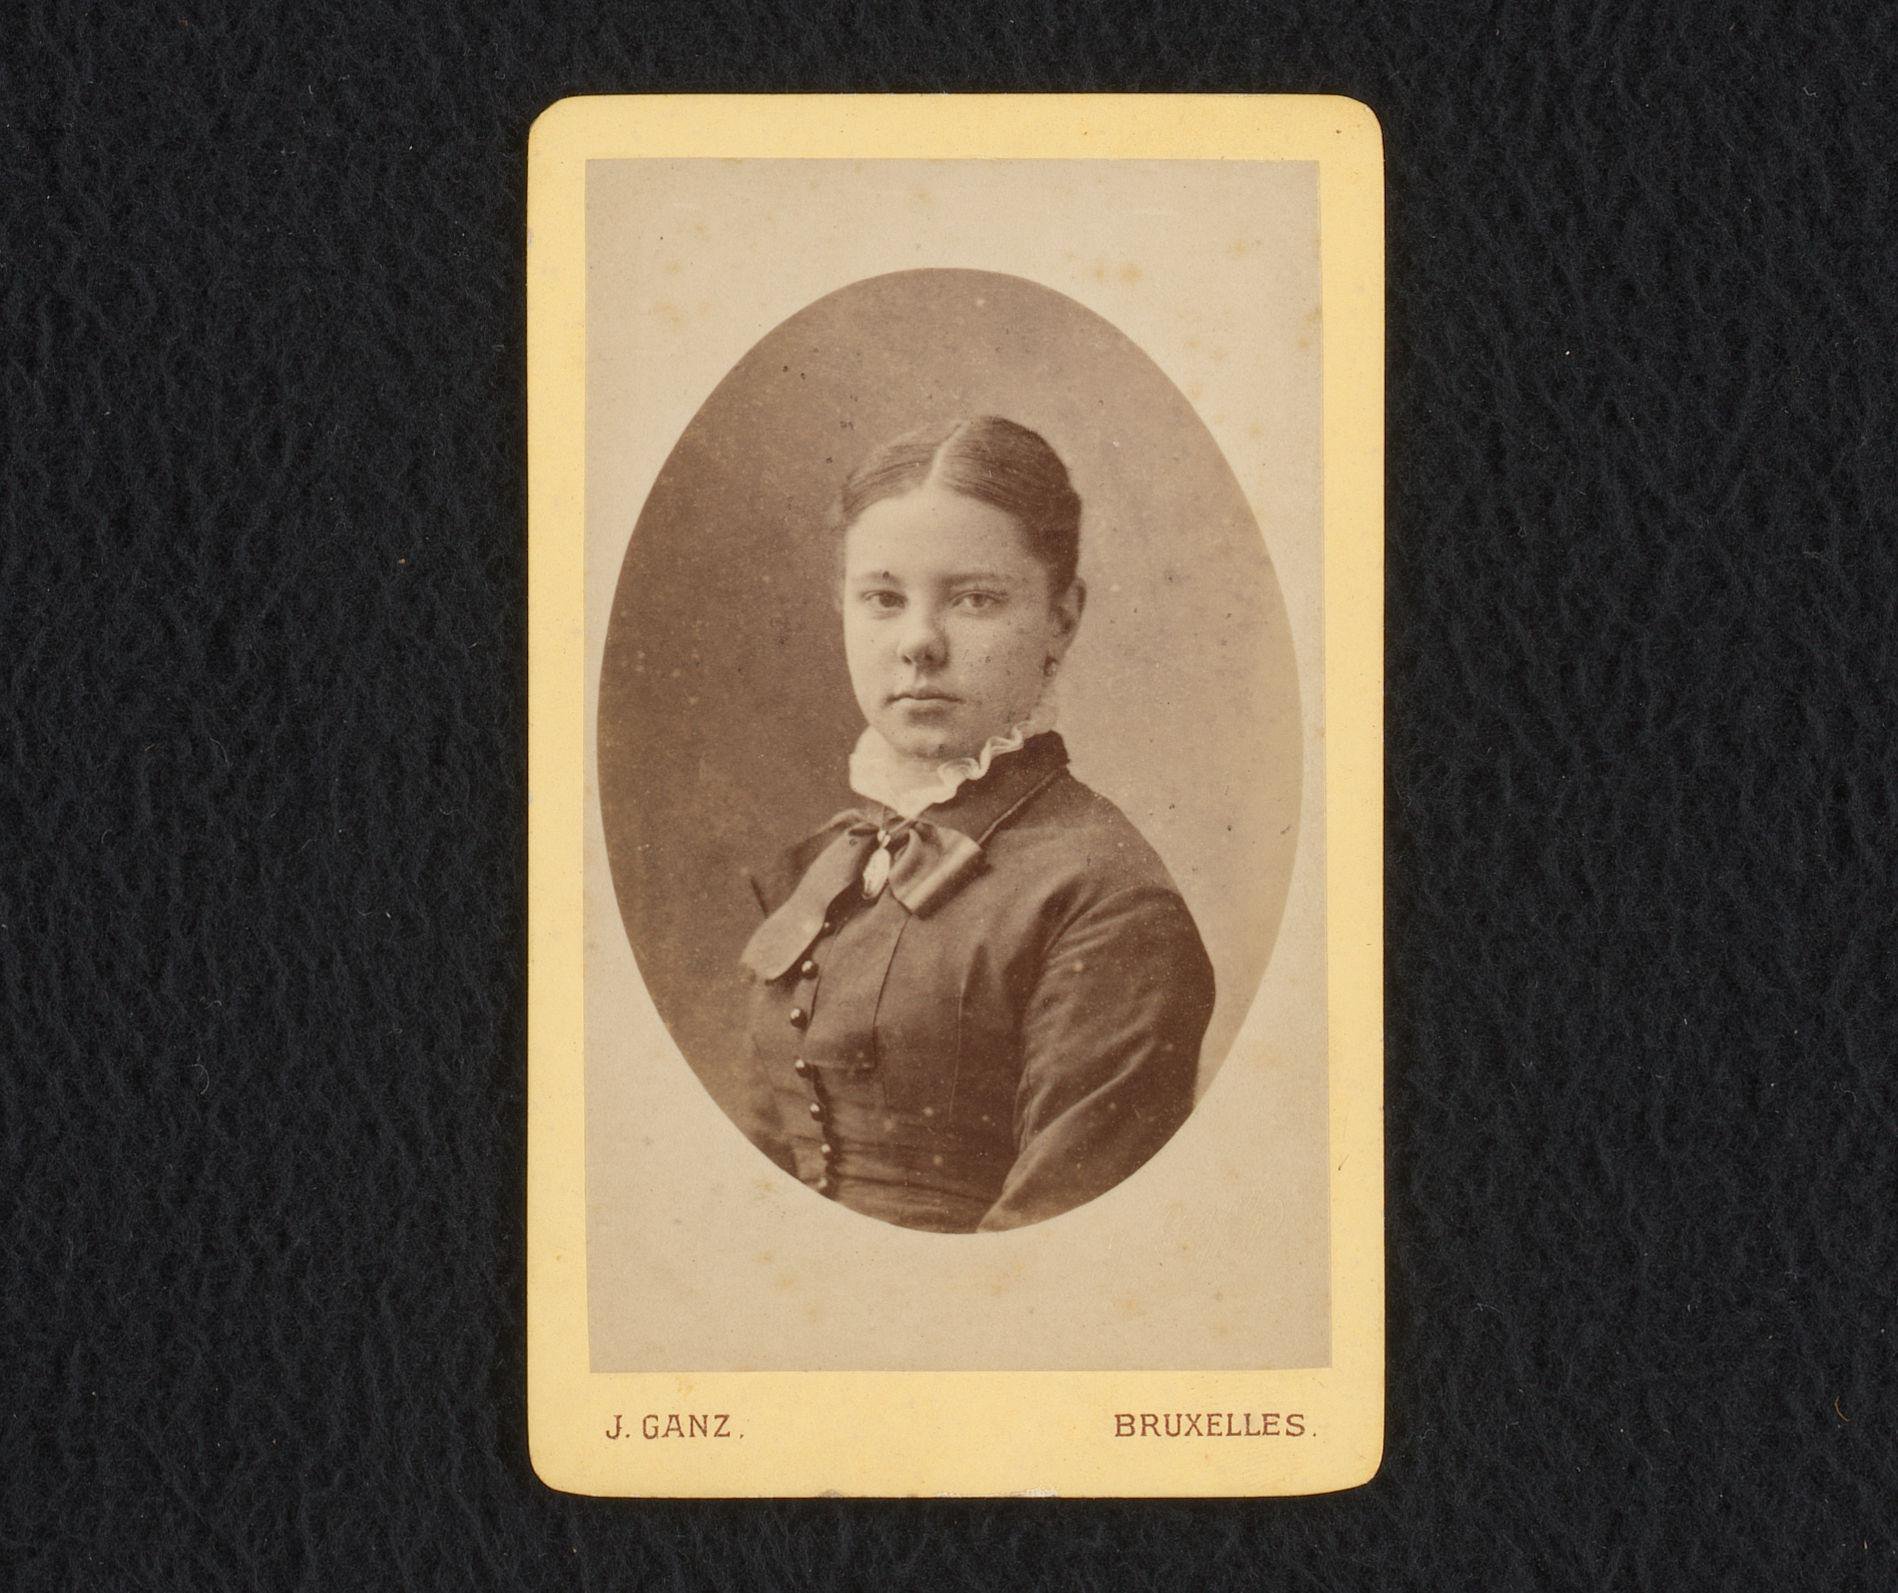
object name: photograph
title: Portret van een onbekende jonge vrouw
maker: julien ganz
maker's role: fotograaf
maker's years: 1844-1892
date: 1876-1890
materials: cardboard, paper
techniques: albumen print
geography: brussels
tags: anonymous historical person portrayed - bb - woman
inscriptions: address: ‘38, Rue de l'Ecuyer/ En face des Galeries St. Hubert/ BRUXELLES/ Même Maison à Zürich.’